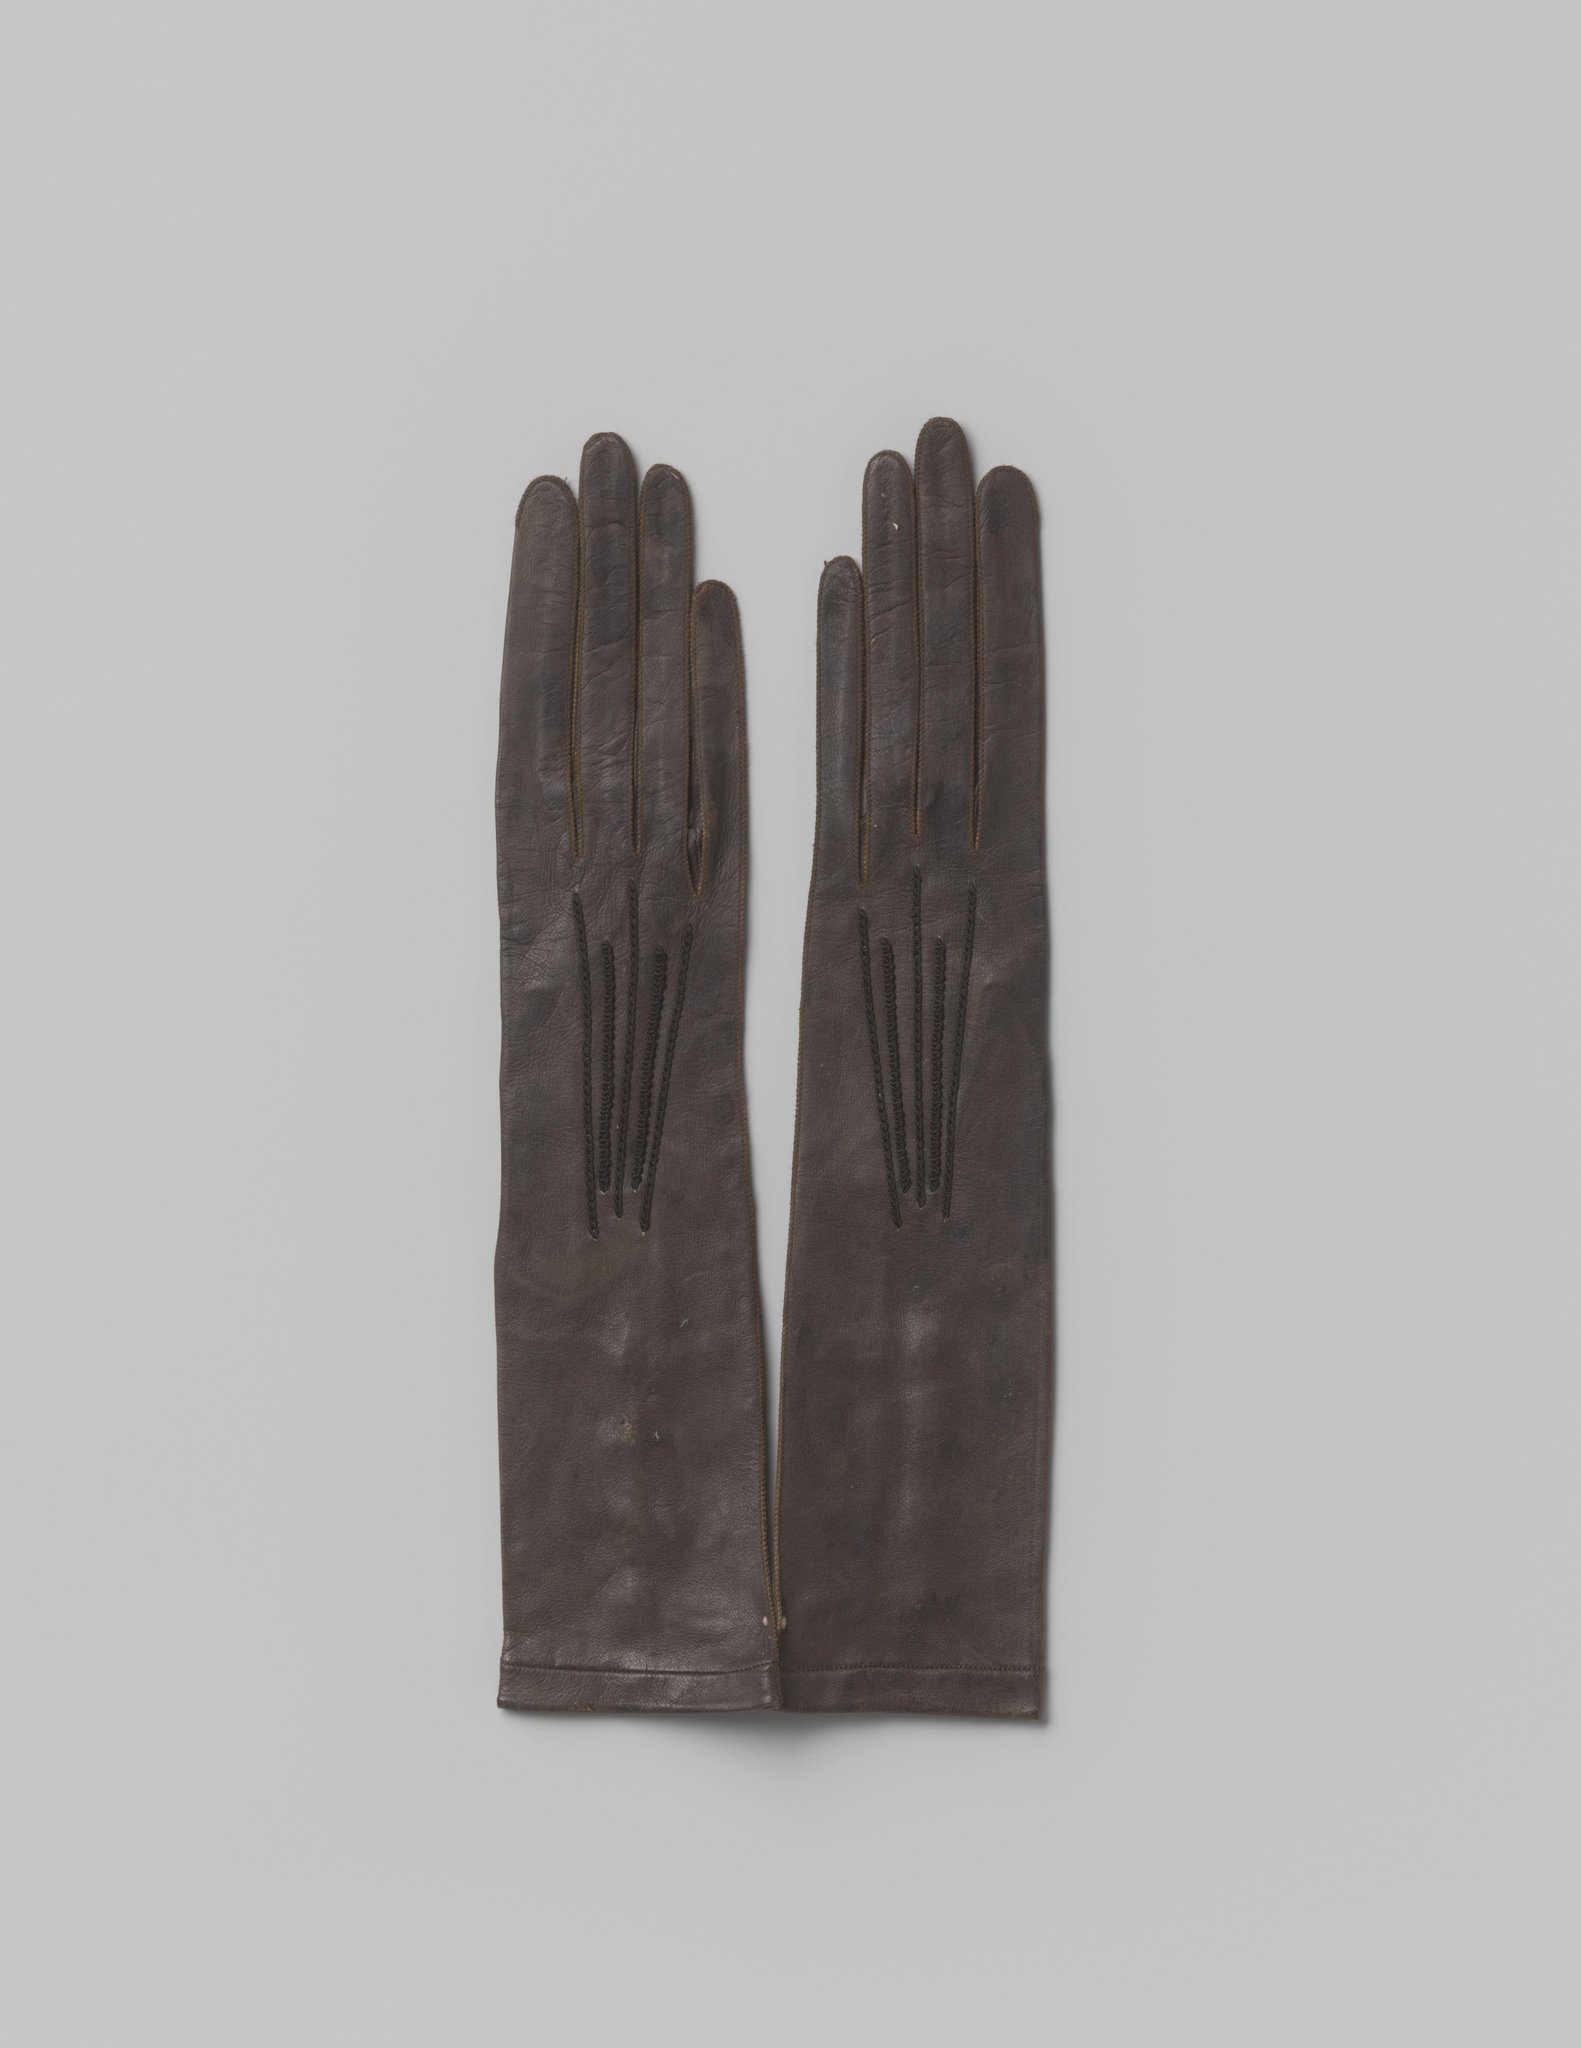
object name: glove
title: Handschoen van donkerbruin glacéleer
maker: Anonymous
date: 1900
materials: copper, metal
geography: western europe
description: Linkerhandschoen van donkerbruin glacéleer. Op de rug versierd met vijf zwarte lijnen. Bij de pols een split met vier metalen knopen. Met extra slanke vingers.